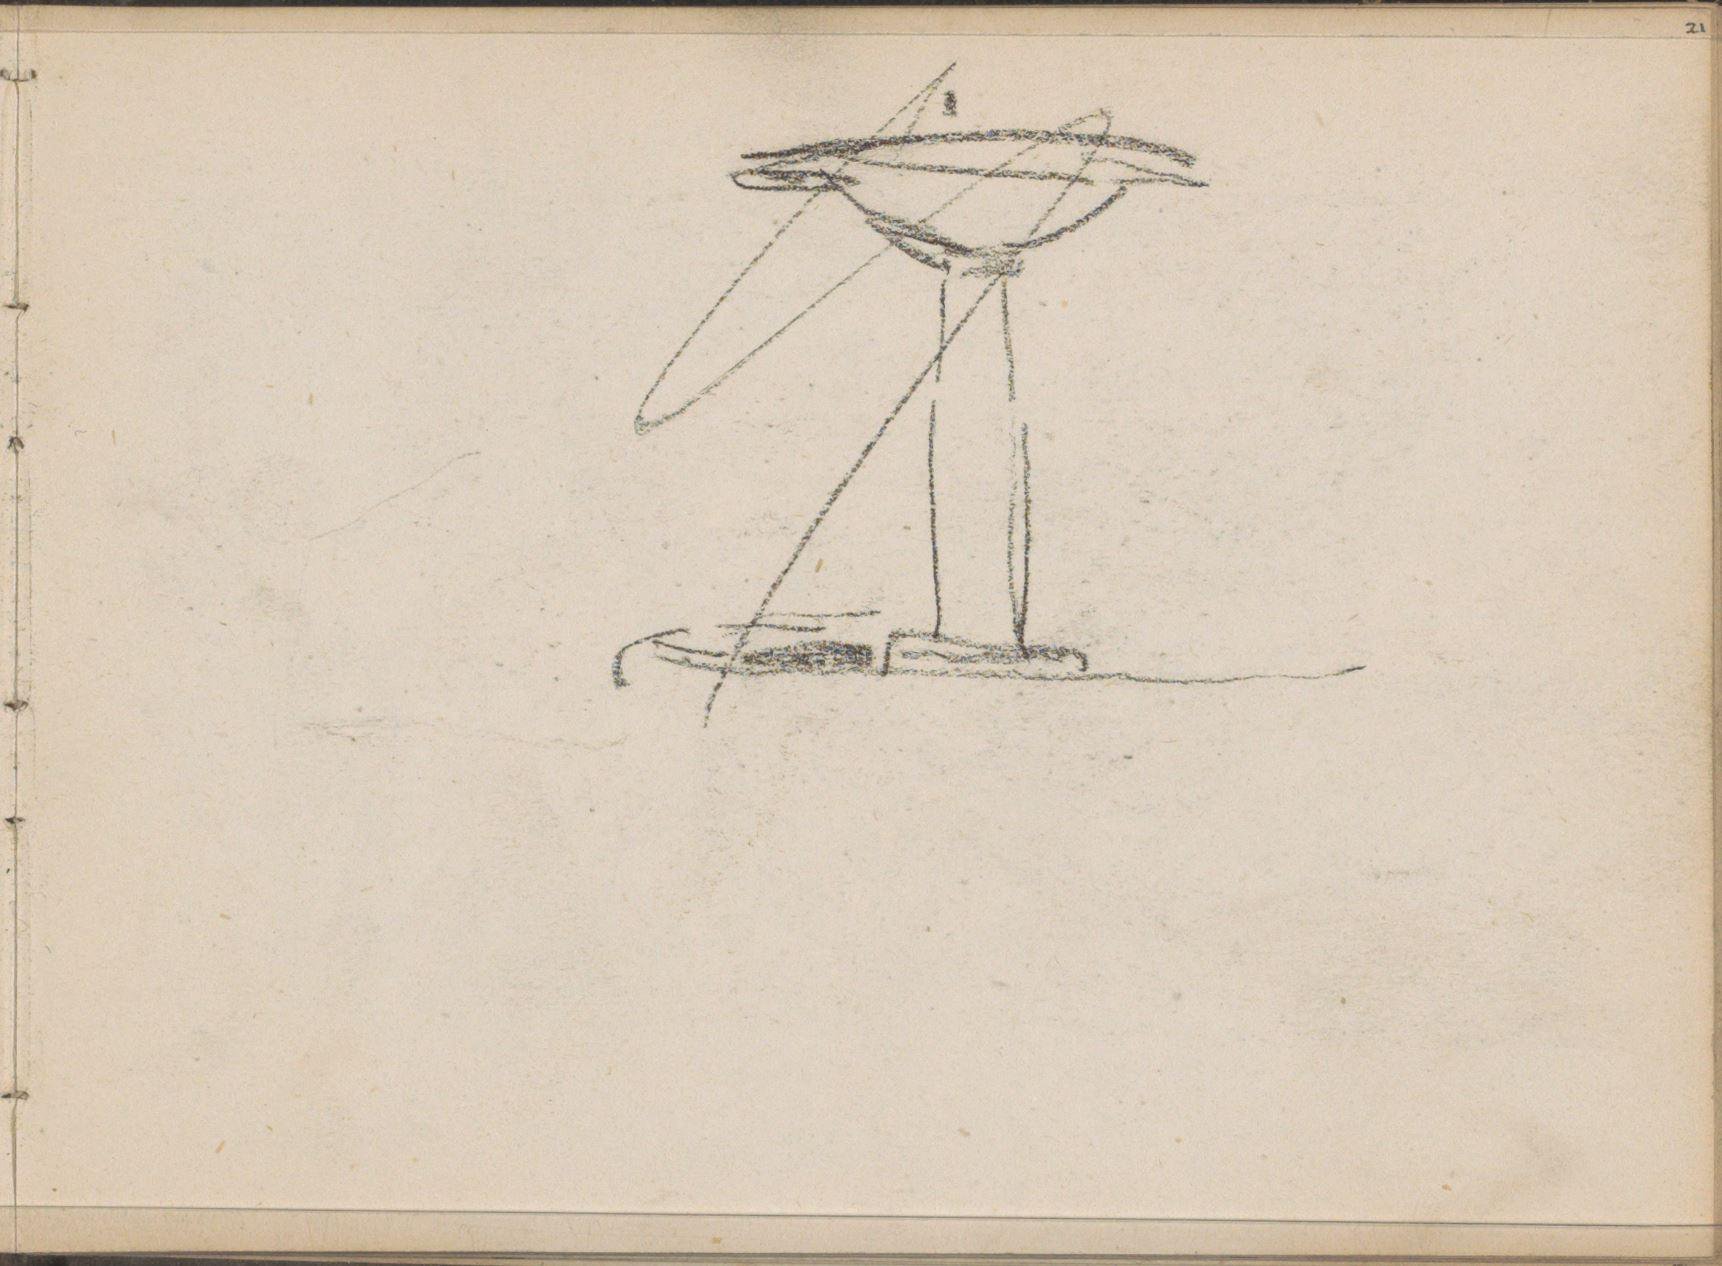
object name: sketchbook leaf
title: Wastafel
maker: marius bauer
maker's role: draughtsman, print maker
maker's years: 1867-1932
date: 1877-1932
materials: chalk, paper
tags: sink, basin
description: Pagina 21 uit een schetsboek met 32 bladen.